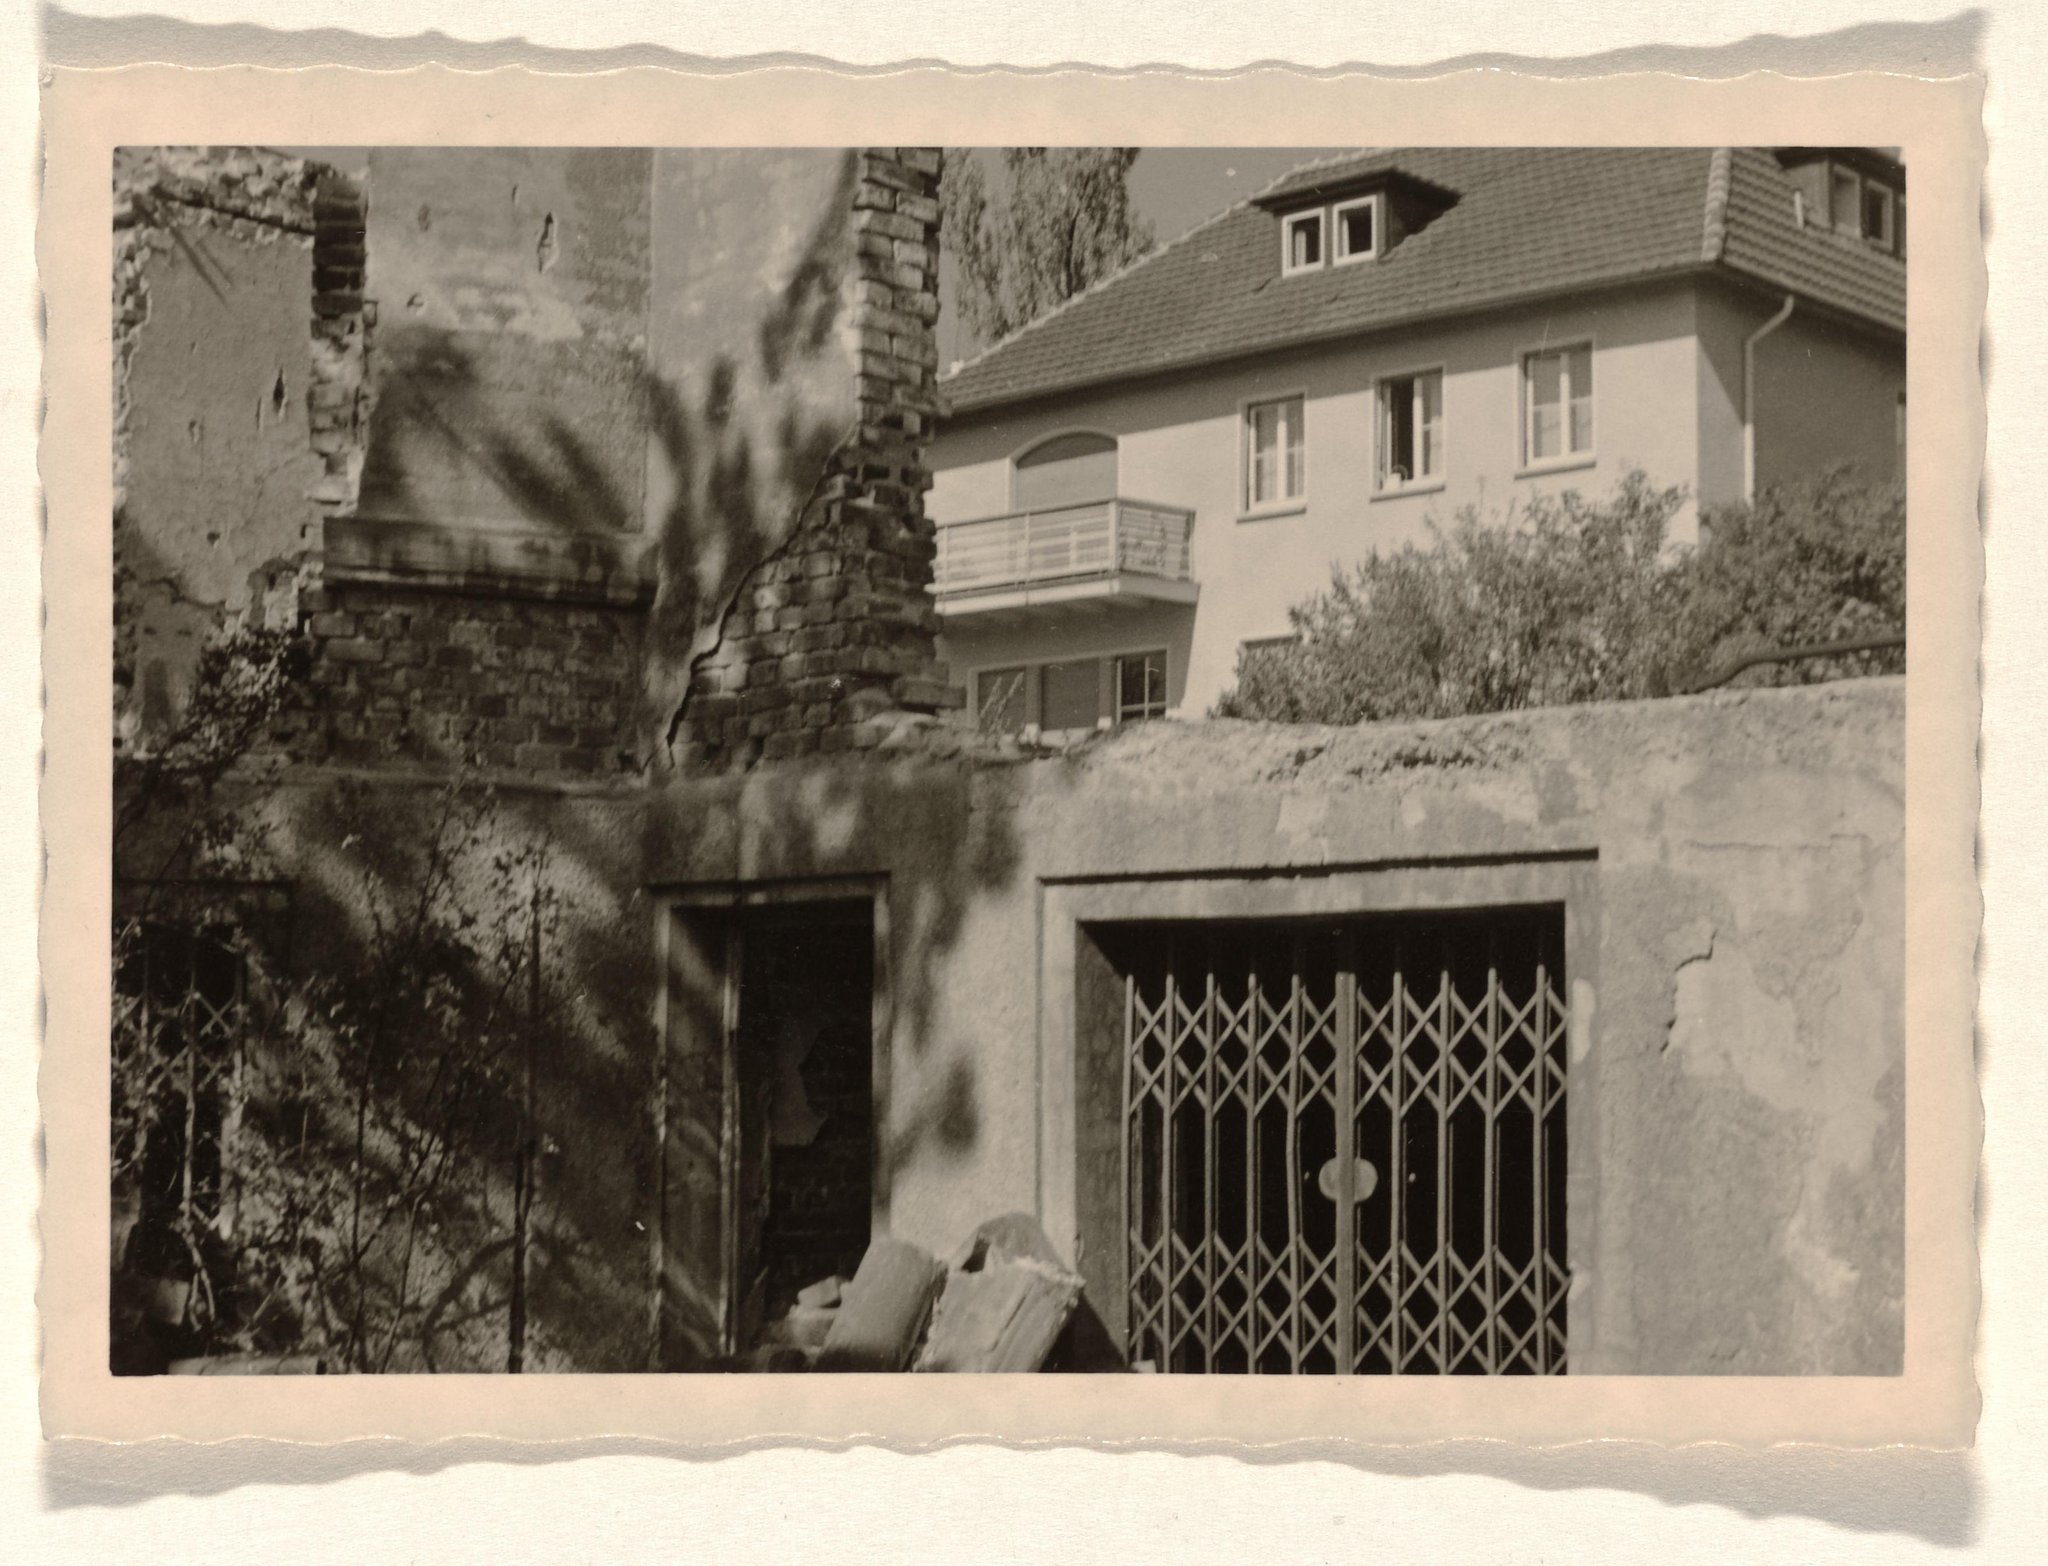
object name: photograph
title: Deel van een ruïne met een schuifhek en een deurgat daarin, met een groot huis met balkon op de achtergrond, met boom en struiken daar omheen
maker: Anonymous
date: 1945-1970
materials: photographic support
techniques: gelatin silver print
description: Deel van een ruïne met een schuifhek en een deurgat daarin, met een groot huis met balkon op de achtergrond, met boom en struiken daar omheen.